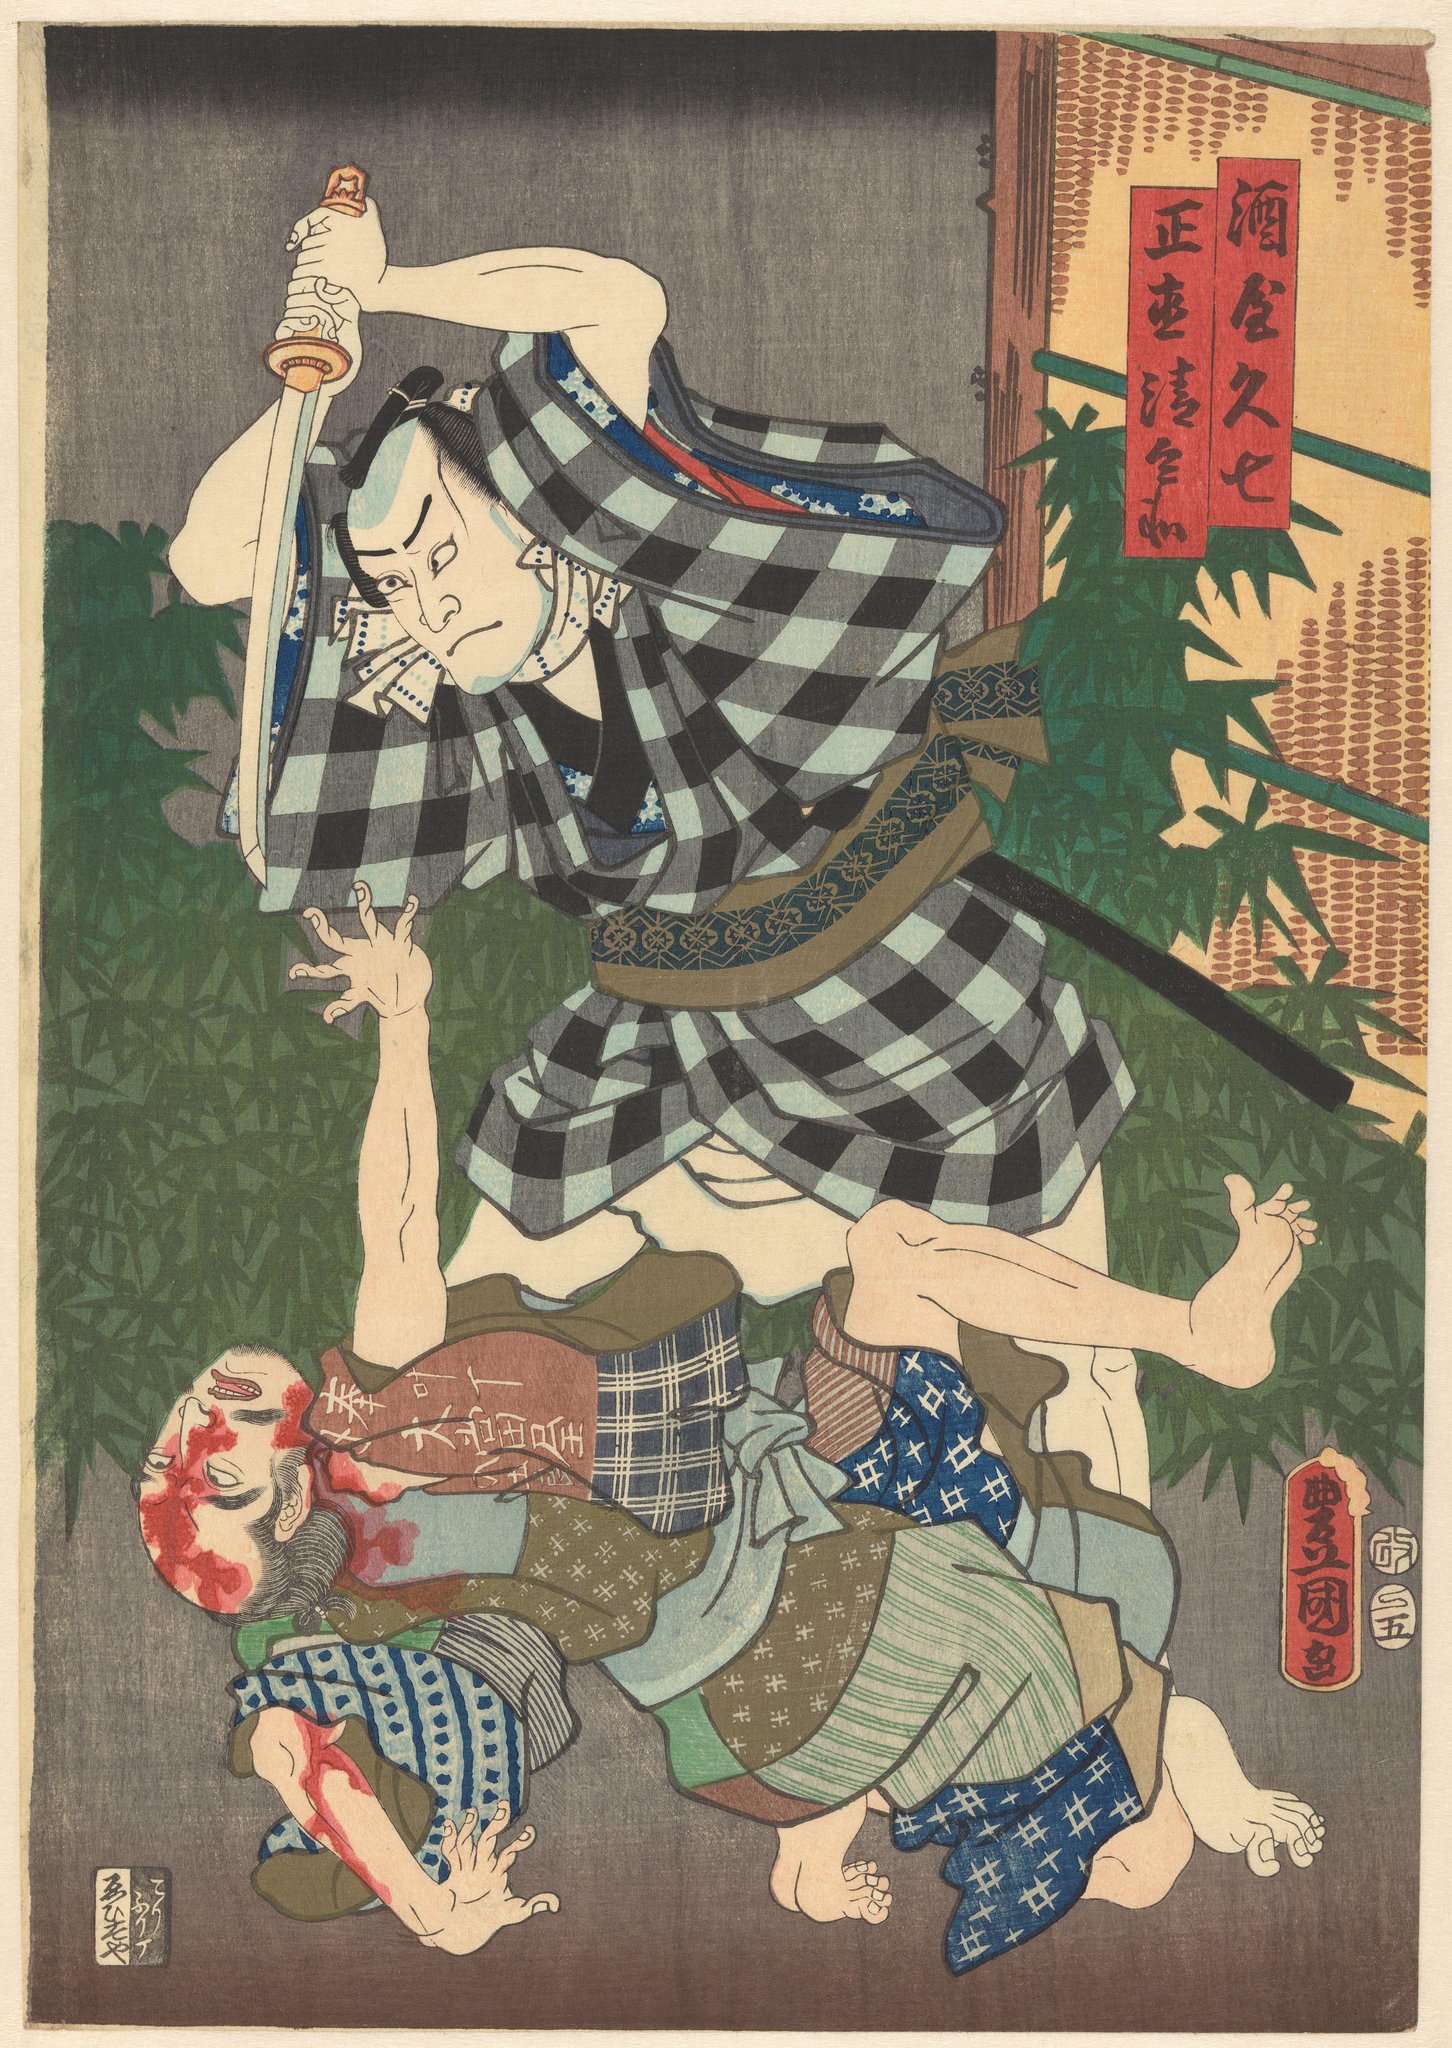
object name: print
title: Seibei vermoord door Kyûshichi.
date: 1805-1857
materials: paper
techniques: woodcut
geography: japan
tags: hacking and thrusting weapons: sword, murderer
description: Seibei met bebloed hoofd, wordt vermoord door de sake handelaar Kyûshichi. (blad van een triptiek)